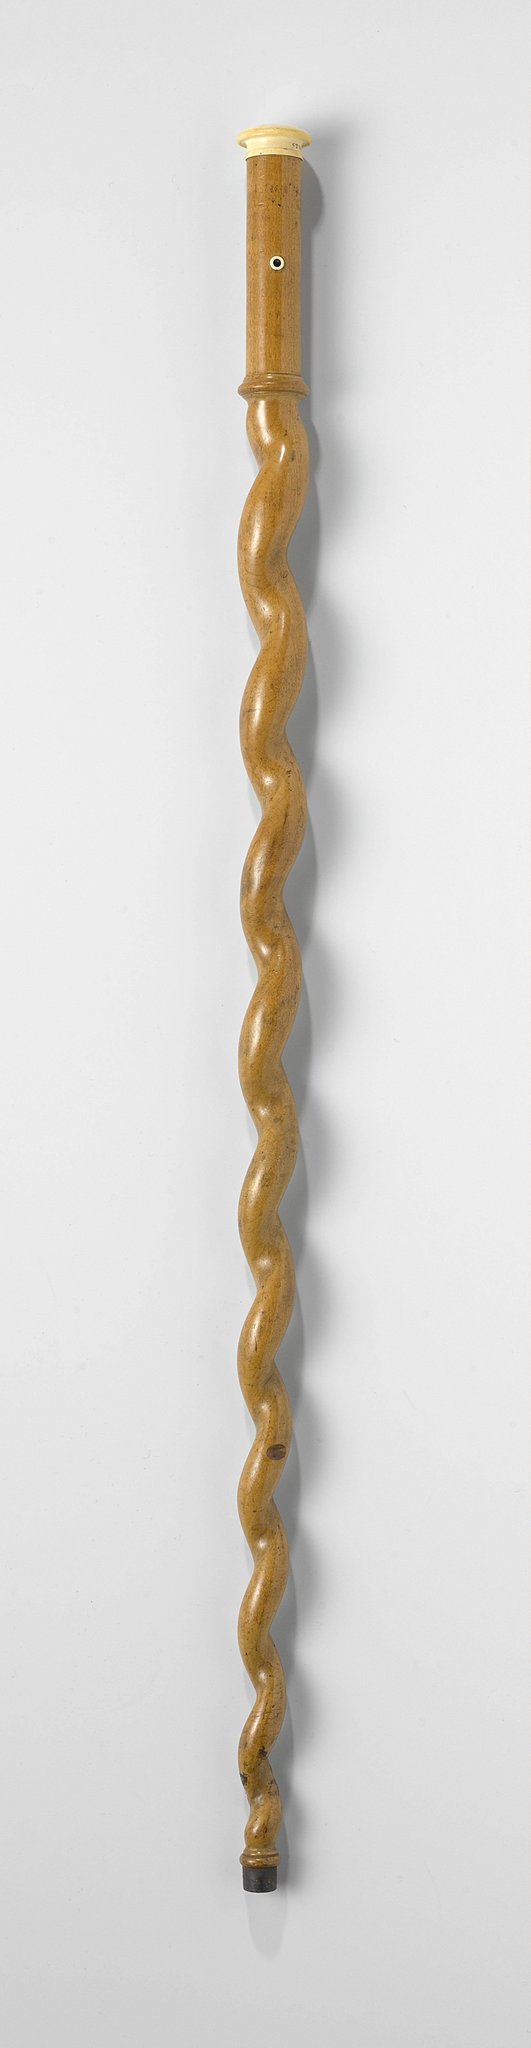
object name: walking stick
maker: Anonymous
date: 1795-1800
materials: ivory, wood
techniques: cutting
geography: netherlands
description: Warped wooden walking sticks were introduced by wealthy and fashionable young Frenchmen, who were called the Incroyables (Incredibles) because of their highly eccentric attire. They were rebelling against the Reign of Terror during the Directoire period (1795–1799). To express their refusal to be subject to this rule, they nicknamed their walking sticks pouvoir executive (executive power).